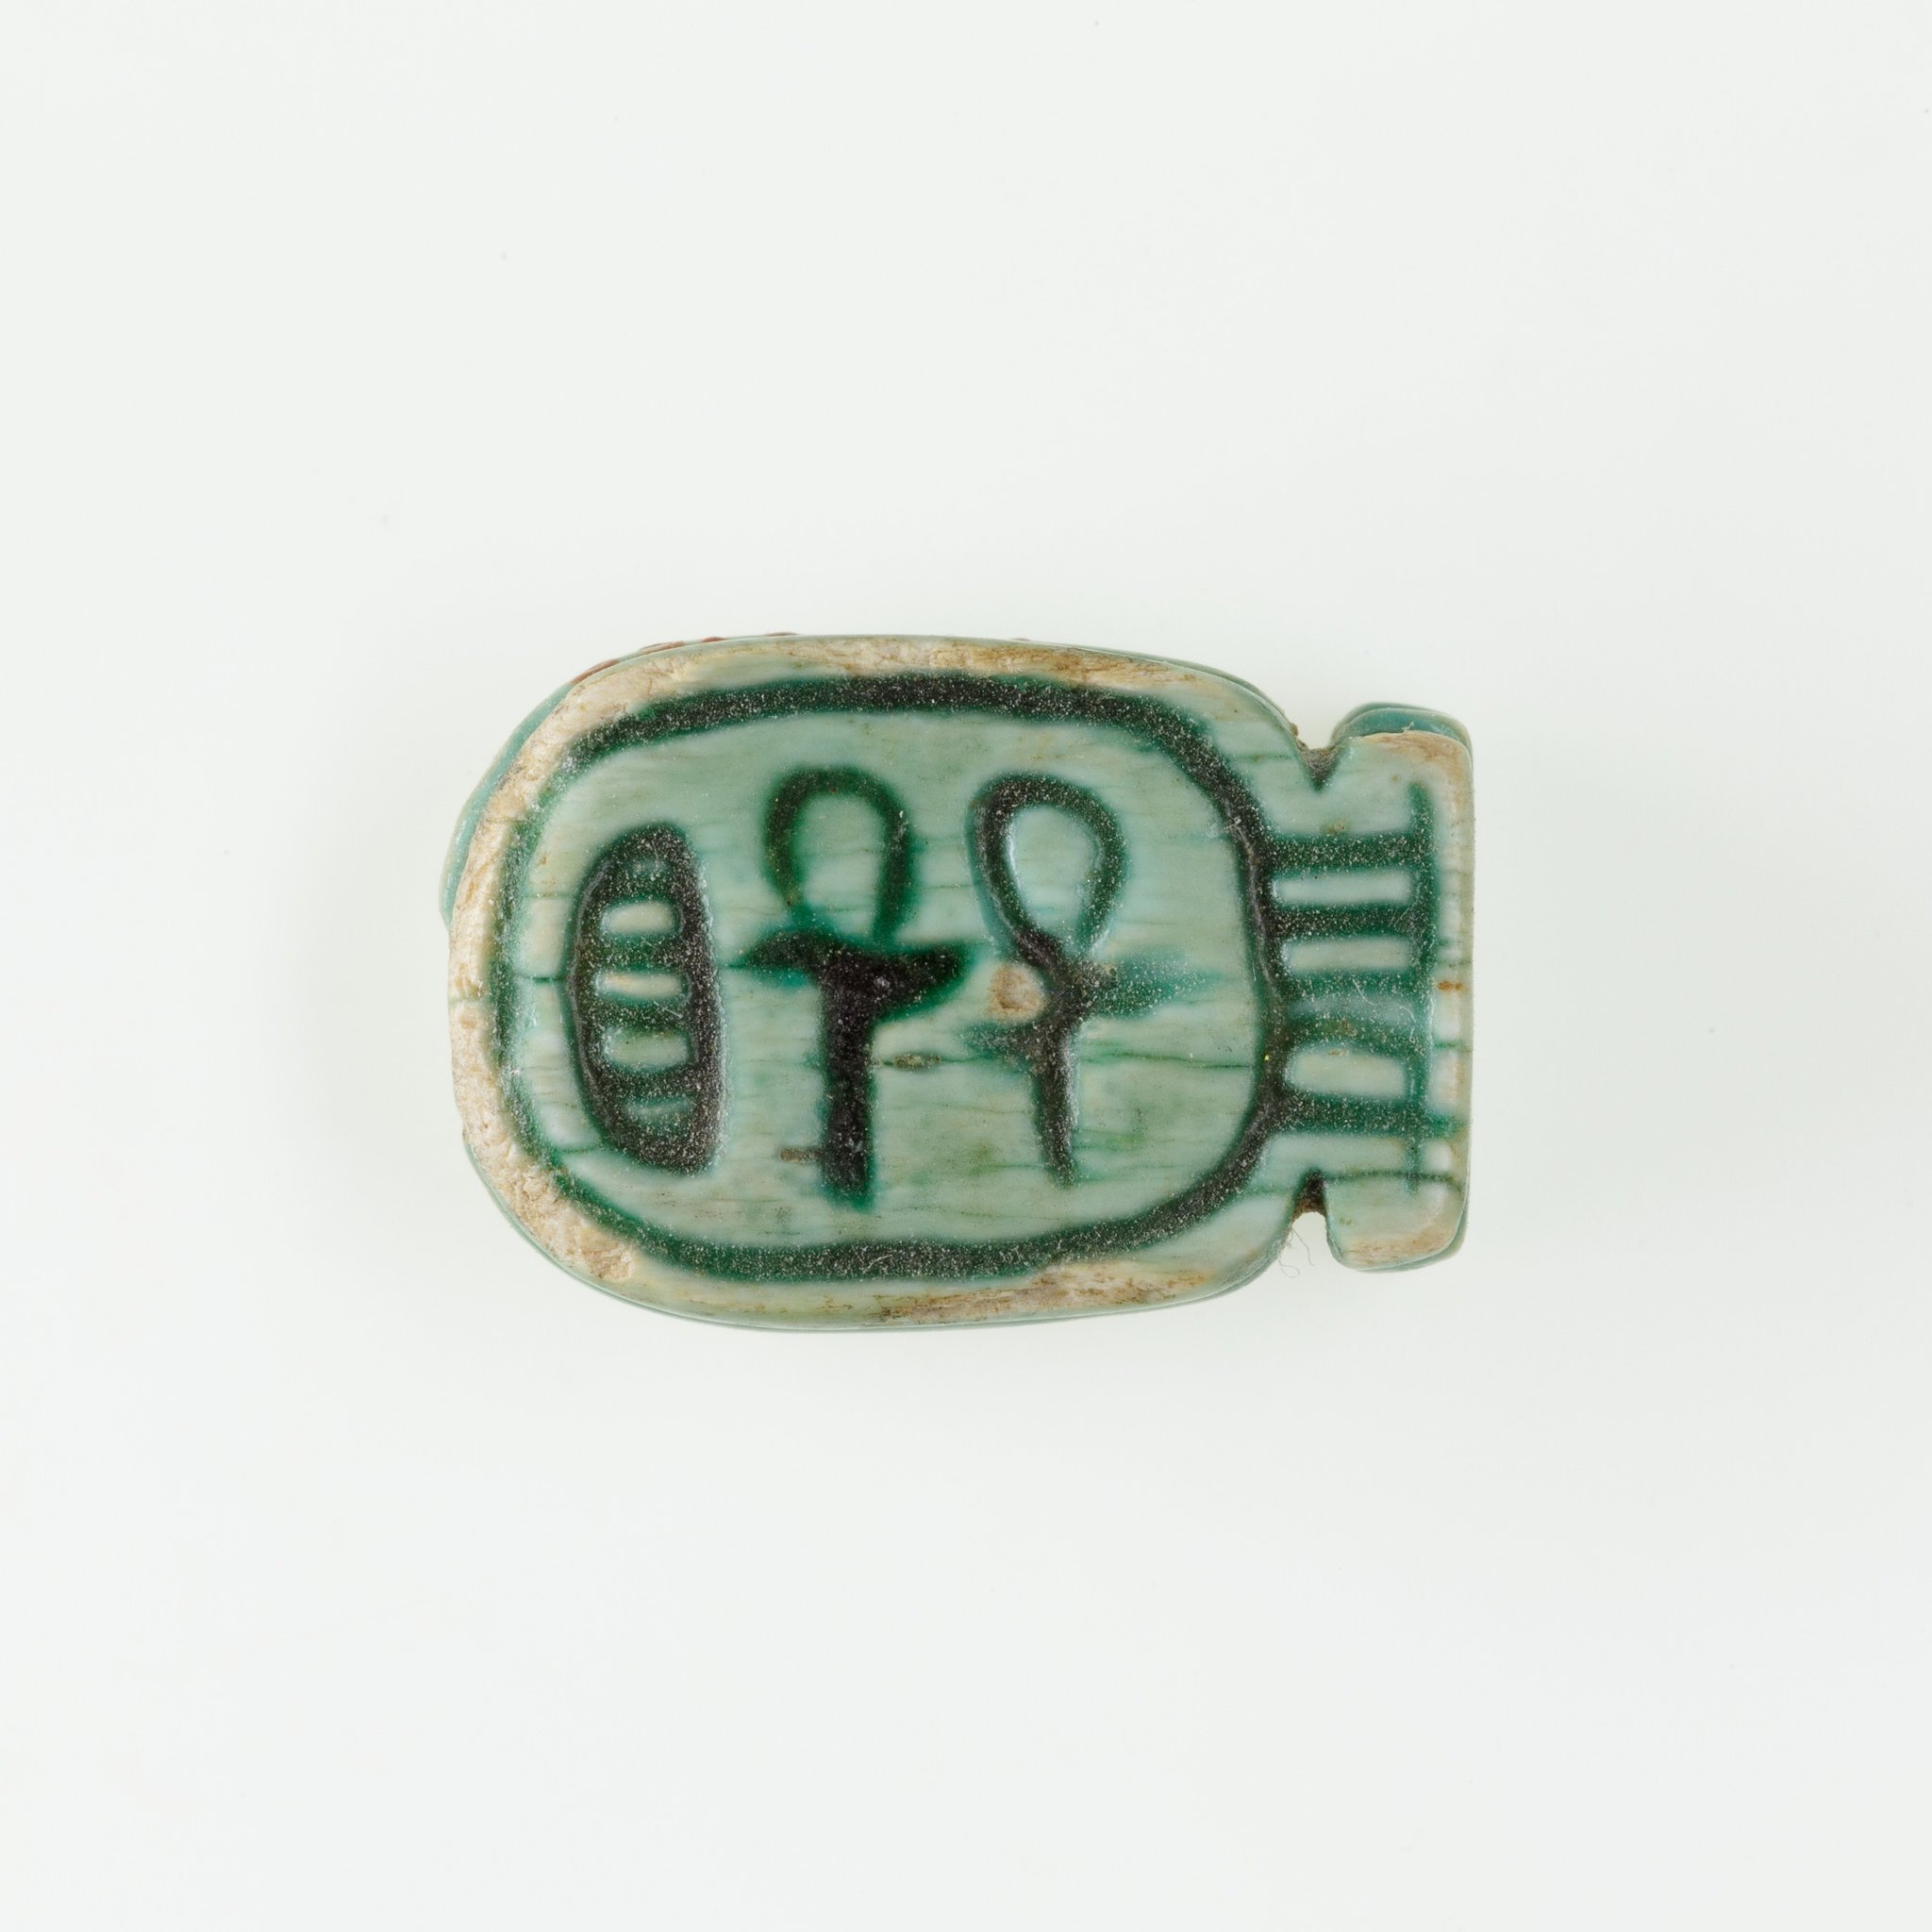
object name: seal plaque, cartouche, ankhs, nefers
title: Plaque in the Form of a Cartouche; two ankhs; ankh, two nefers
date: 1492-1473 BCE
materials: stone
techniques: glazing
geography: egypt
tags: cartouches,hieroglyphs